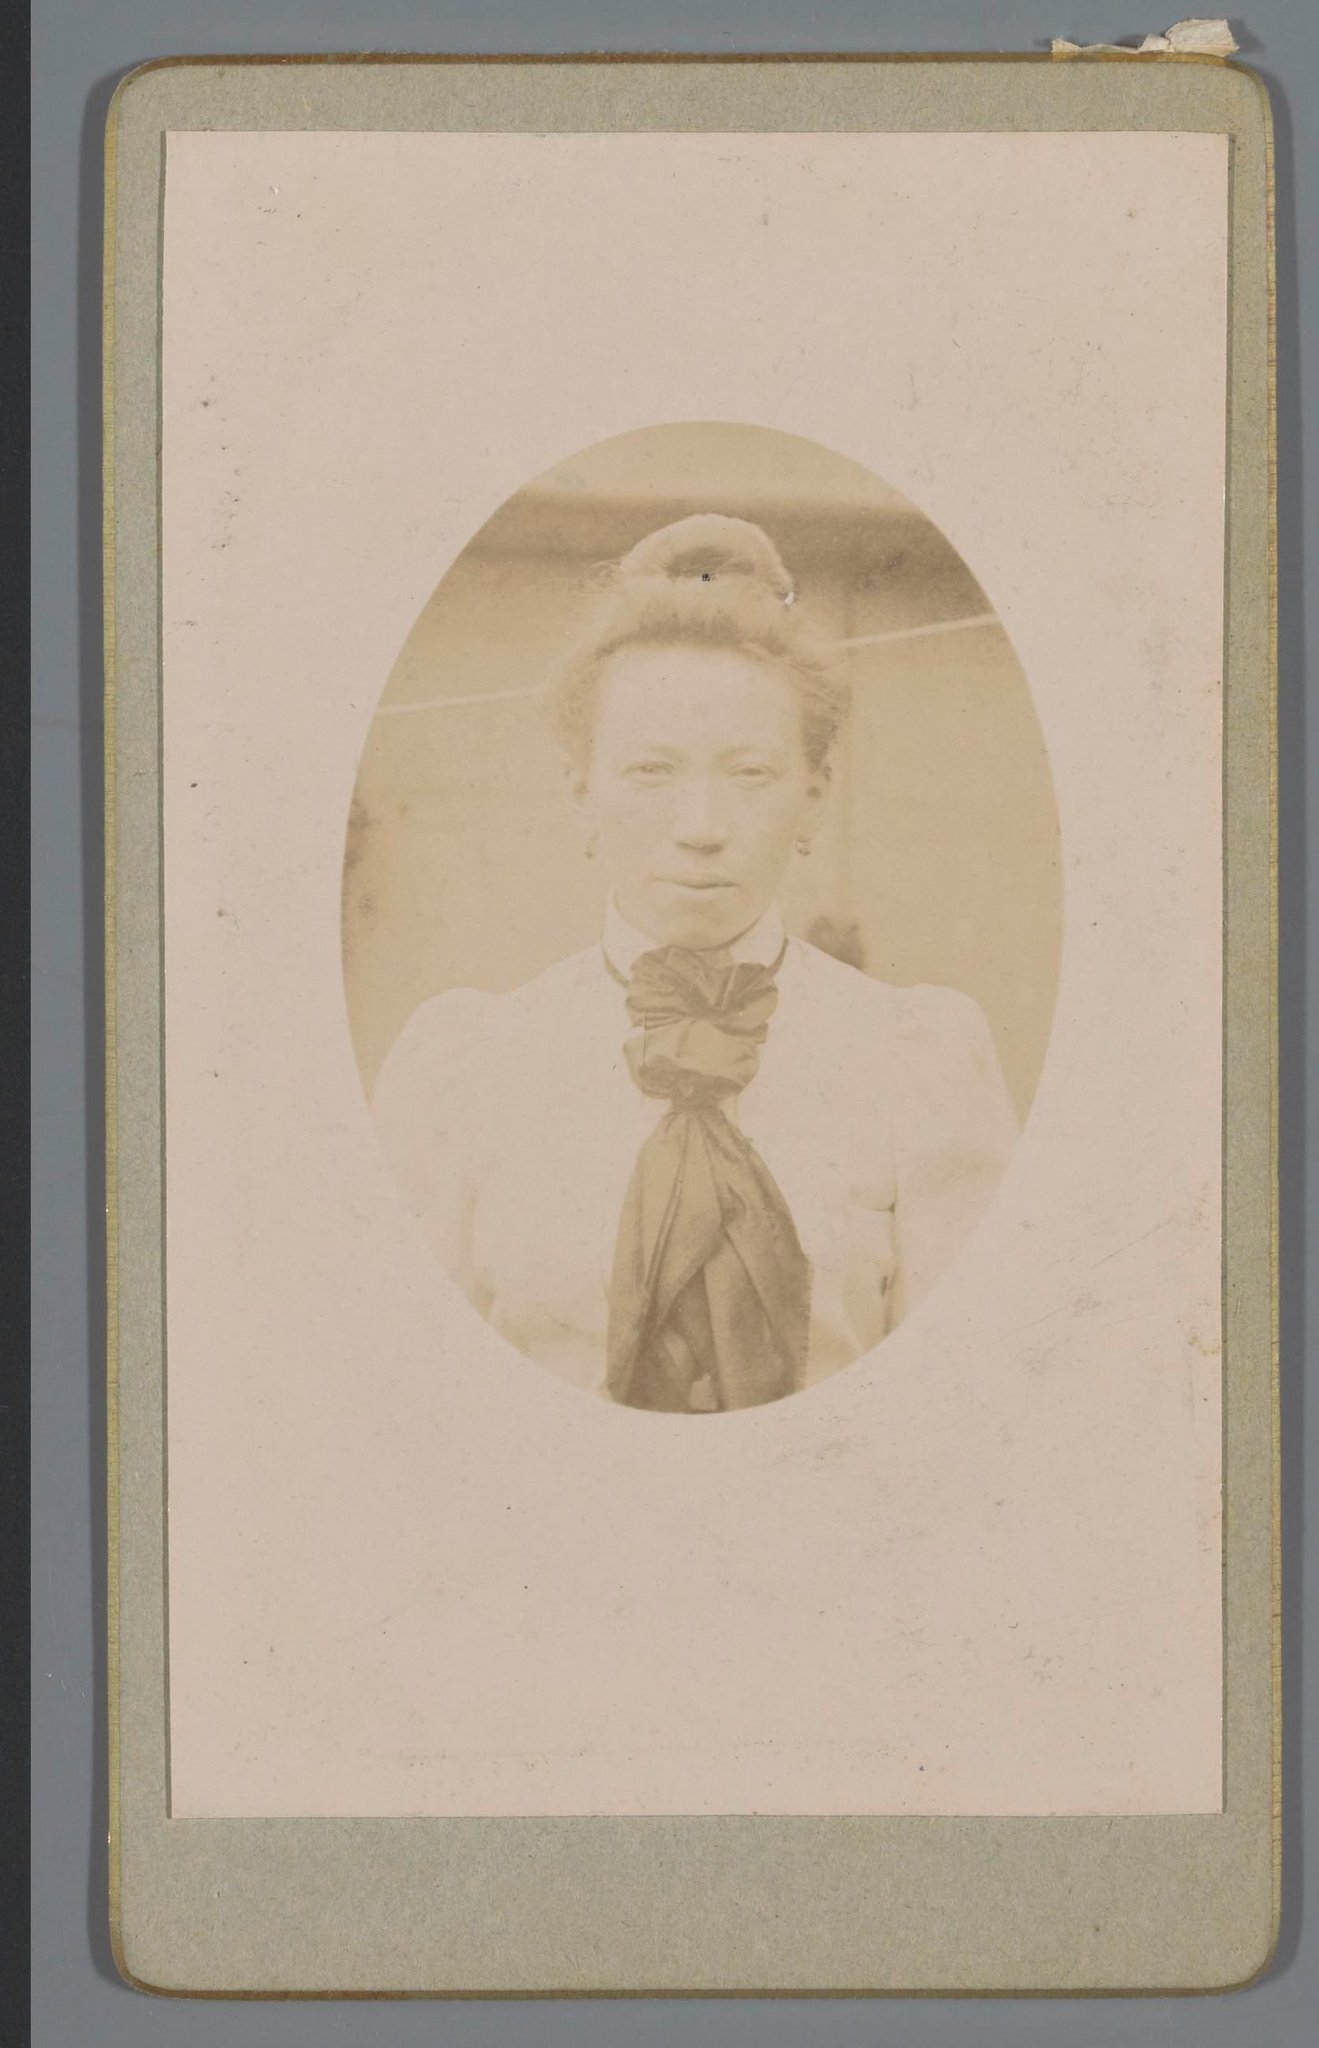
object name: carte de visite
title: Portret van een onbekende vrouw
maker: Anonymous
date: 1880-1910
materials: paper, cardboard, celluloid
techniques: collodion silver print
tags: adult woman, anonymous historical person portrayed